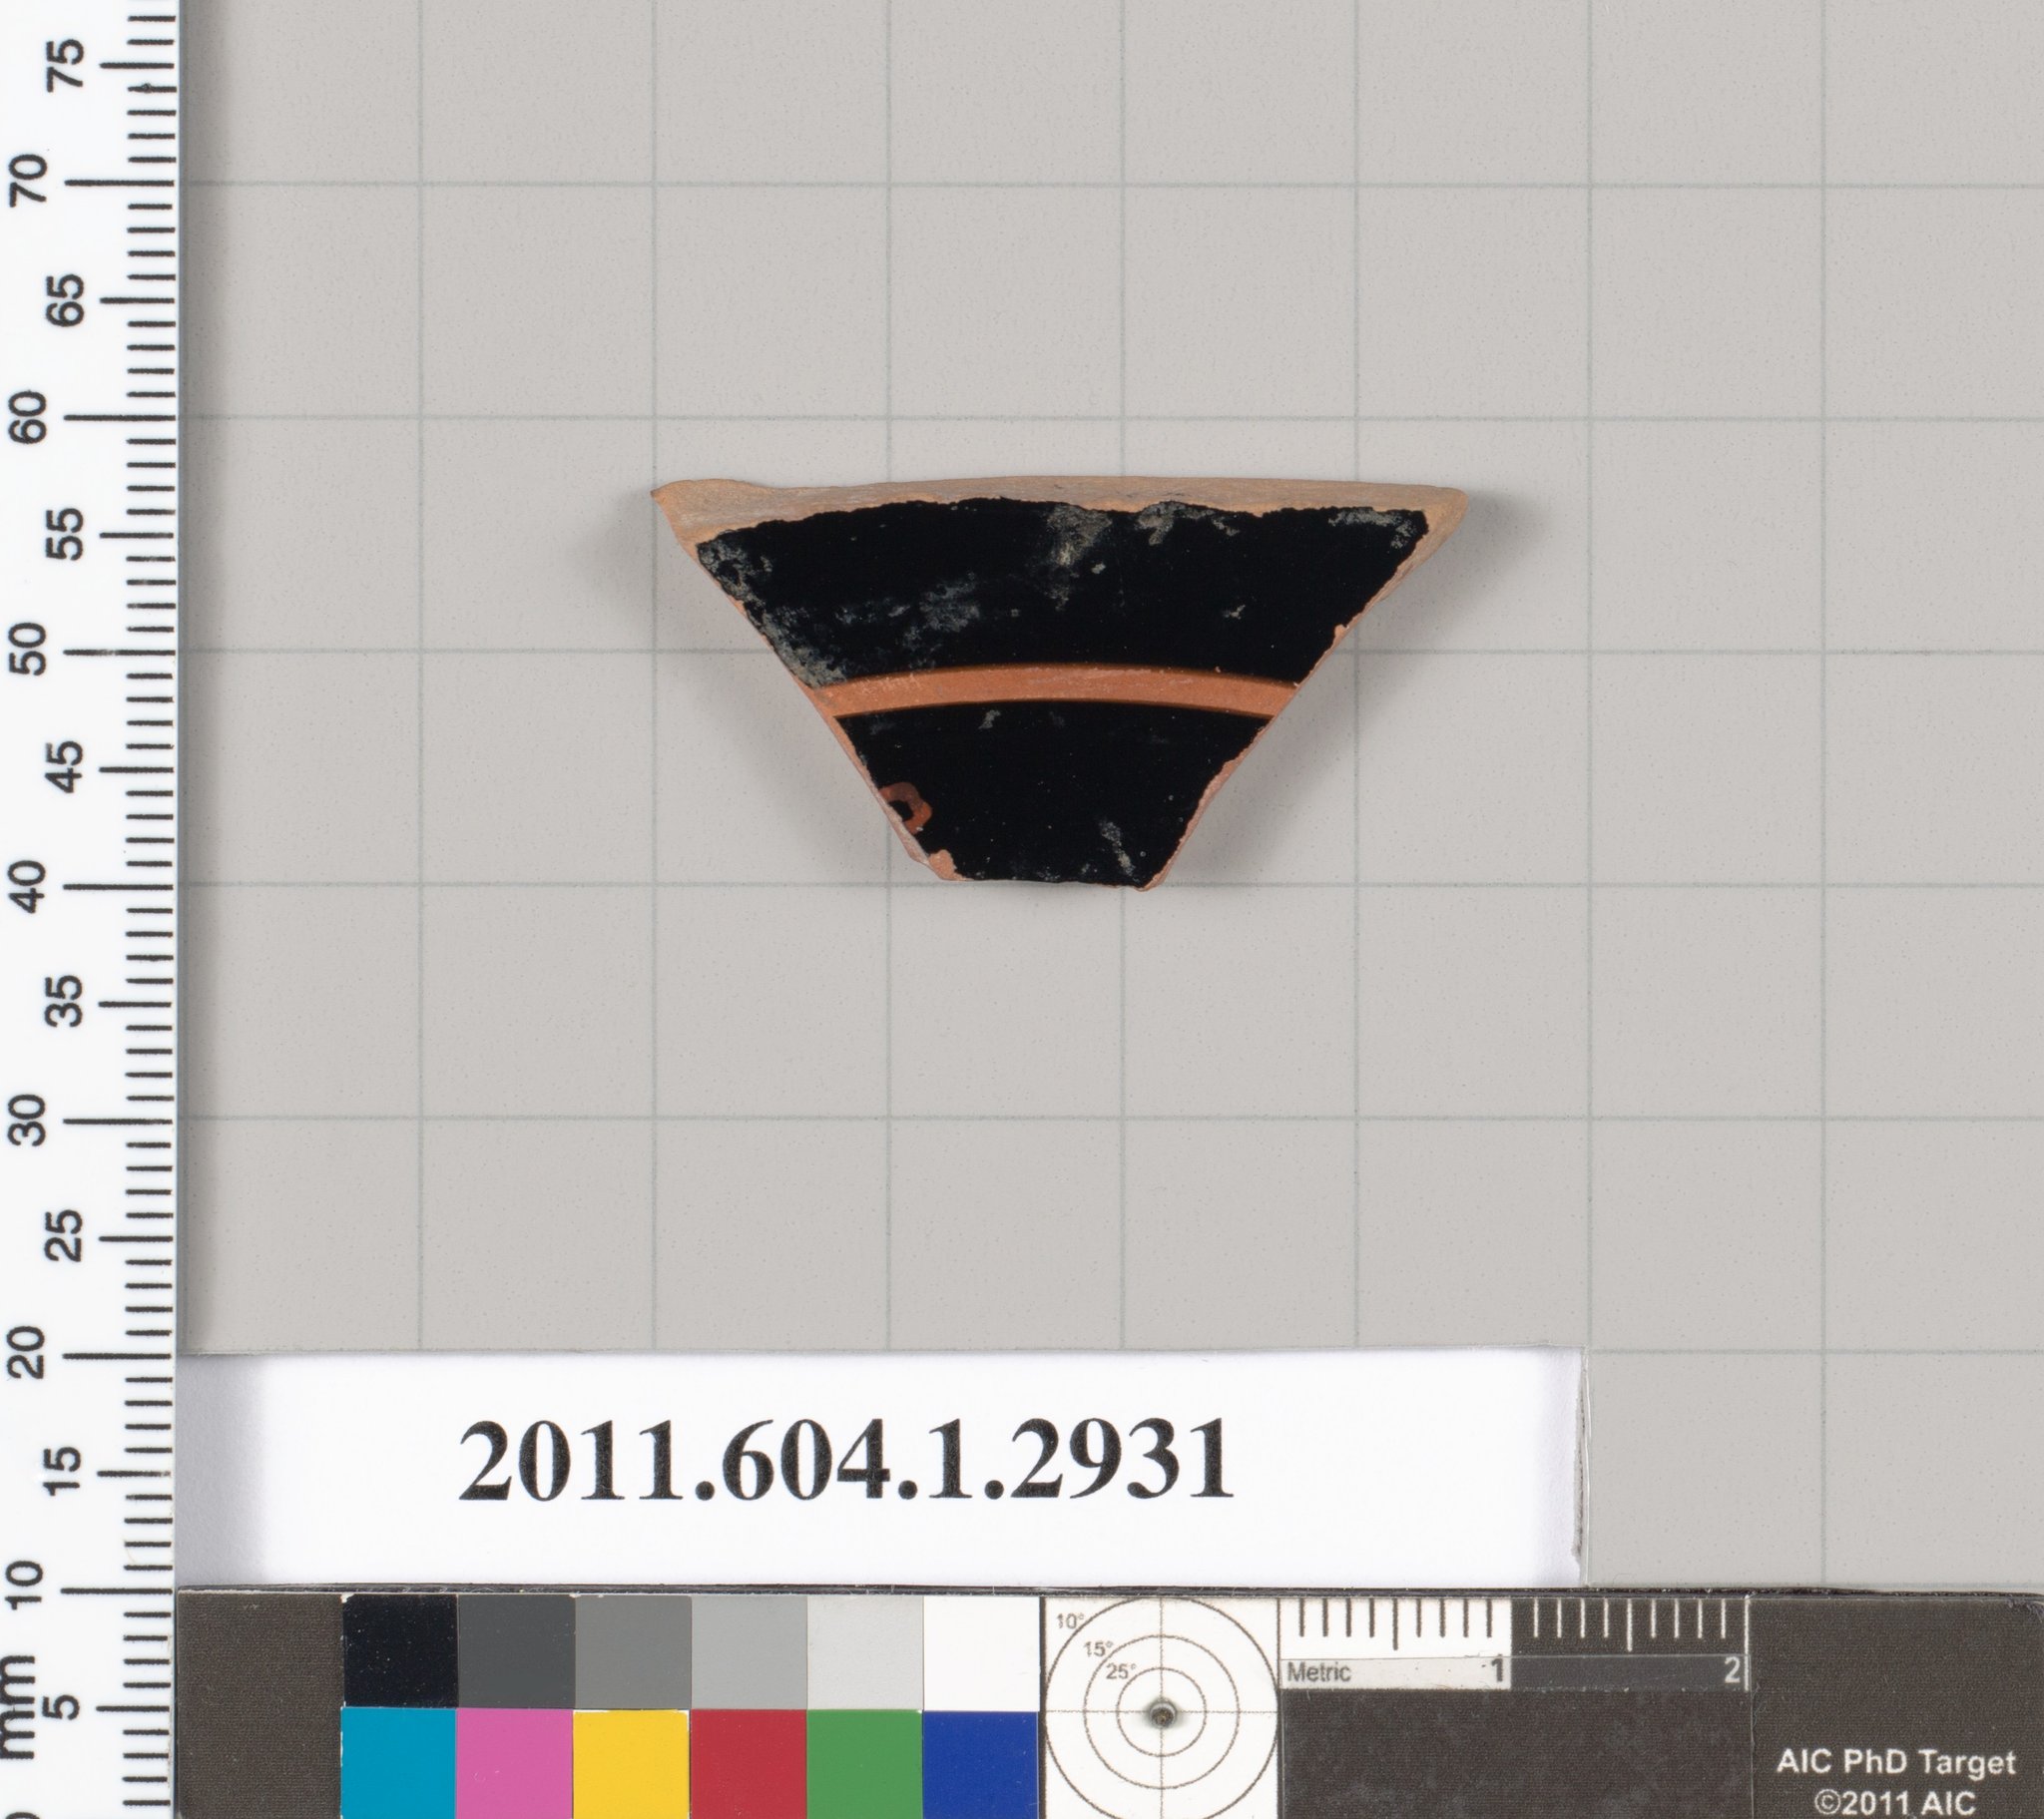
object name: kylix fragment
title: Terracotta fragment of a kylix (drinking cup)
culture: greek, attic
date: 600-401 BCE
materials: terracotta